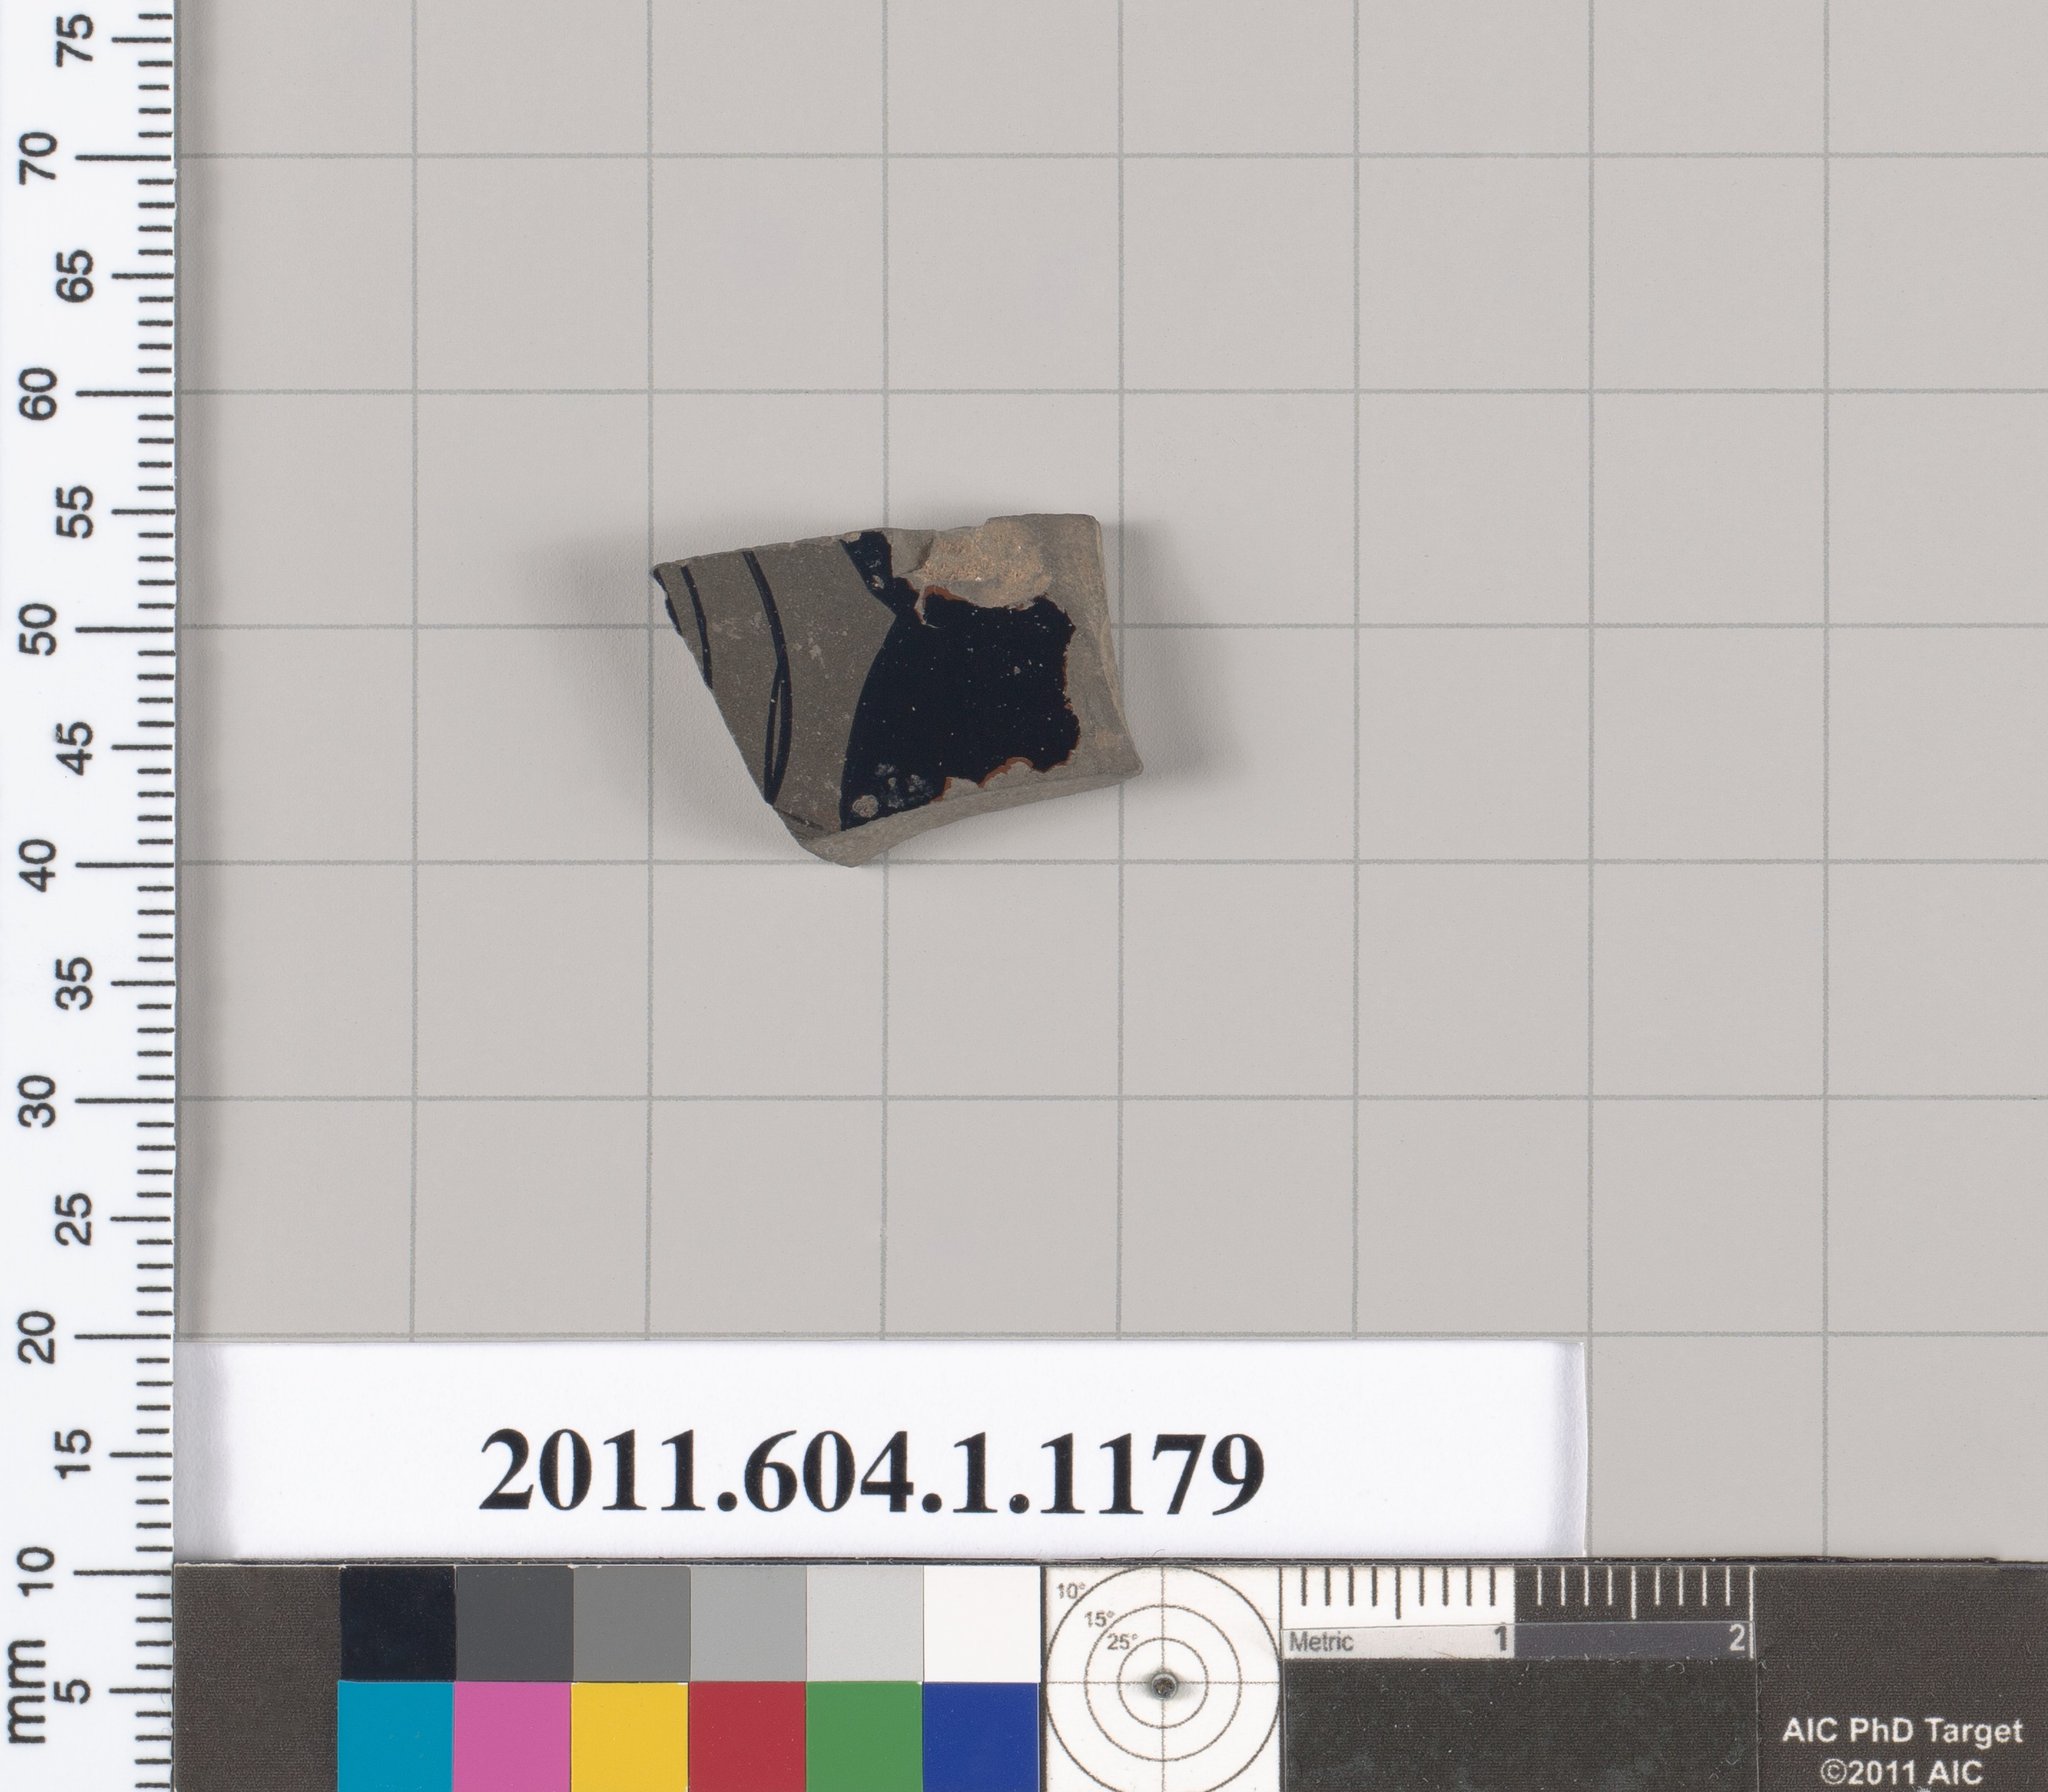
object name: kylix fragment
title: Terracotta fragment of a kylix (drinking cup)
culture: greek, attic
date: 490-480 BCE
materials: terracotta